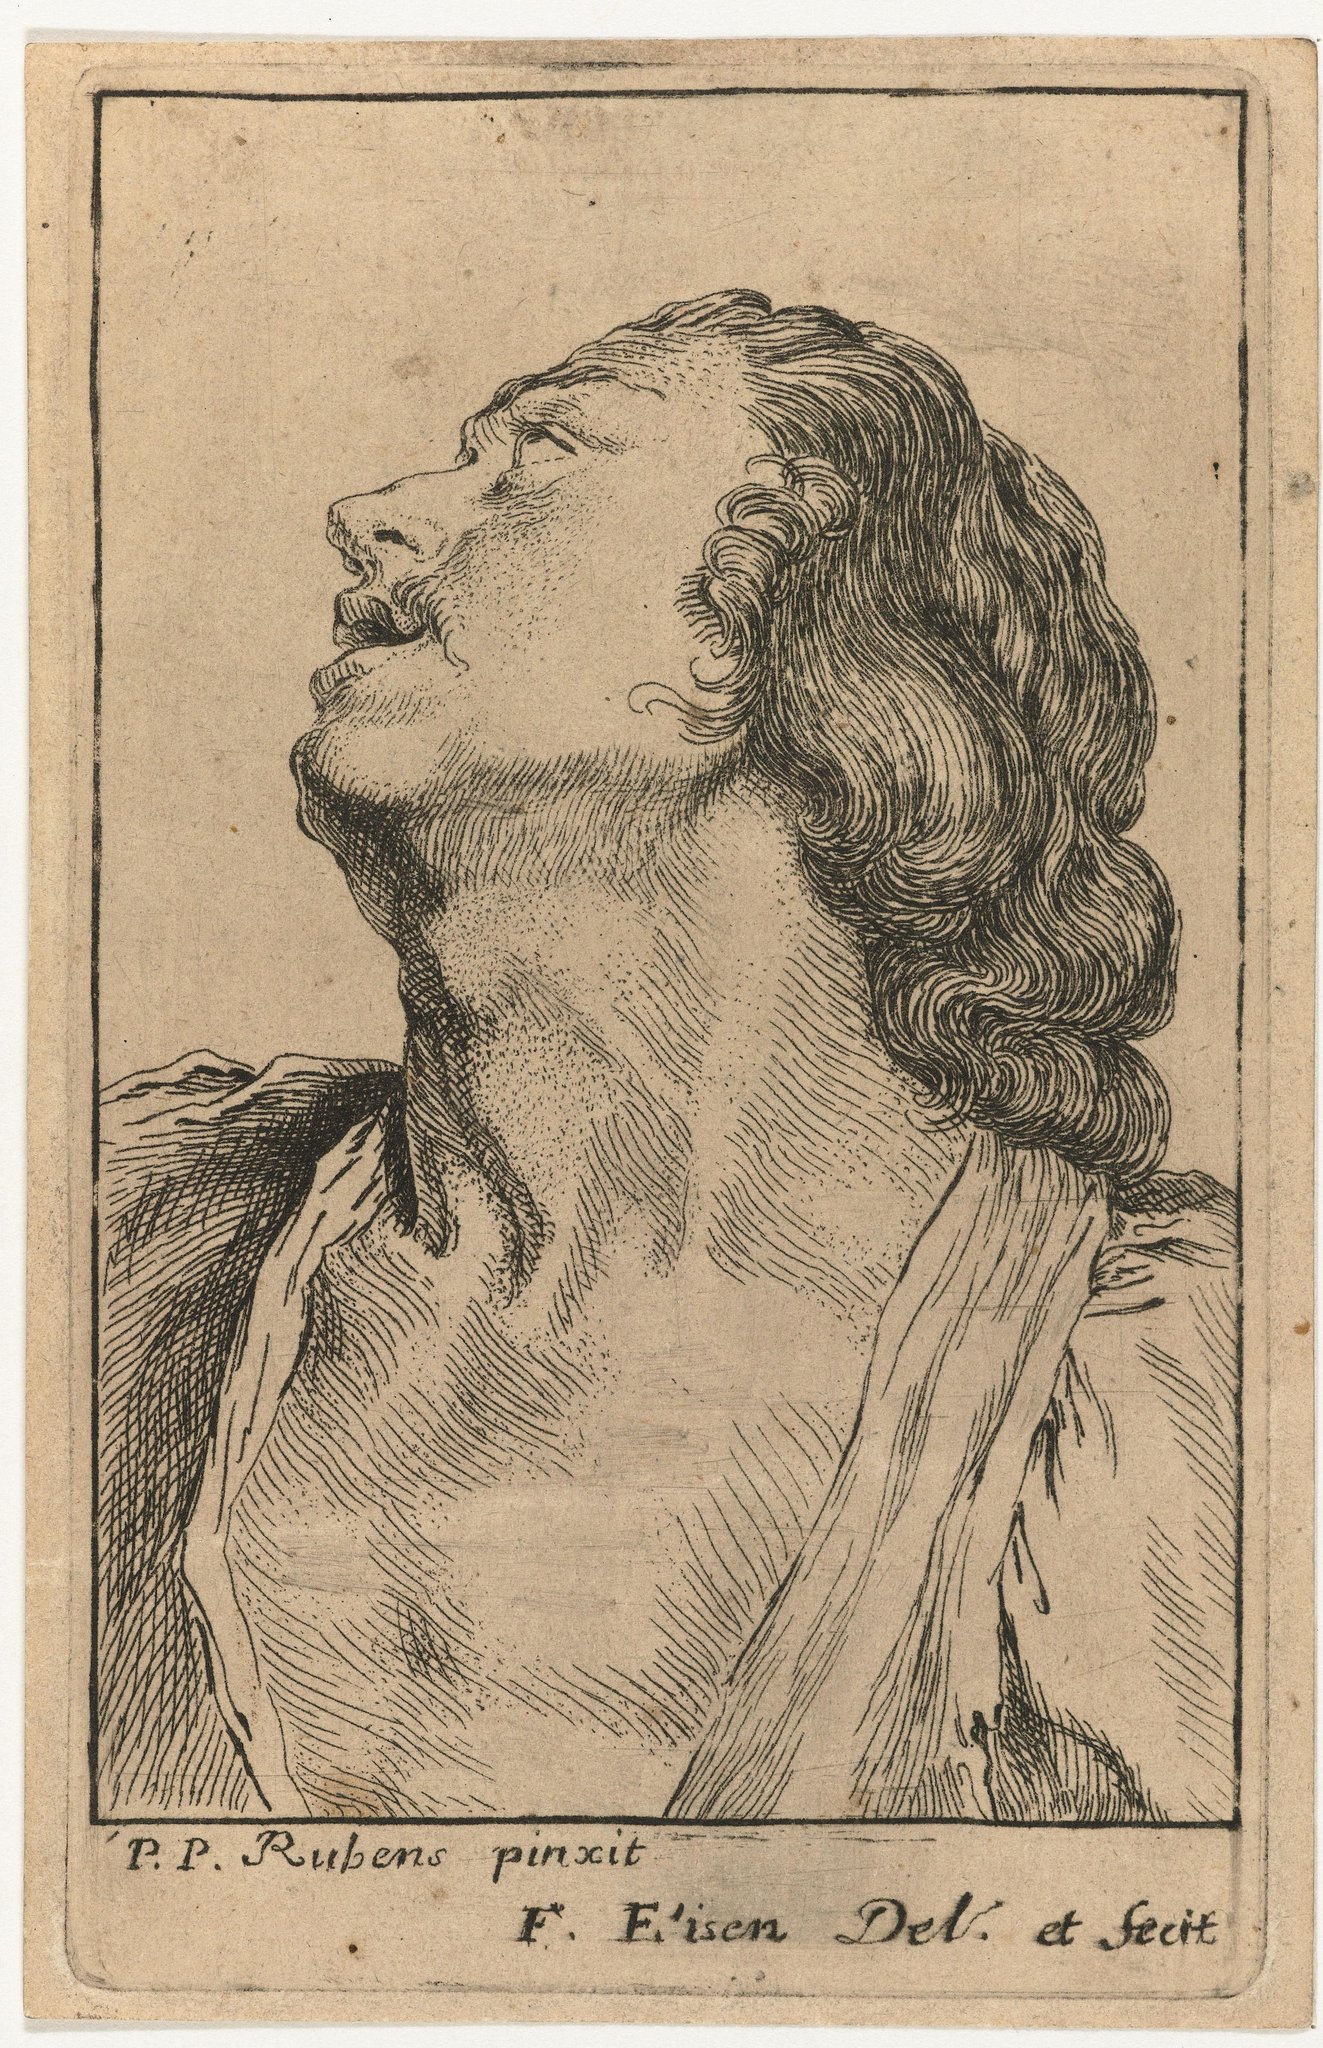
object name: print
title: Borstbeeld van een jongeman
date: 1705-1778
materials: paper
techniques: etching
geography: paris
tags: adult man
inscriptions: collector's mark: Lugt 2228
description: Studiebeeld. Borstbeeld van een jongeman met lang haar, hij buigt het hoofd dat in profiel links is gewend naar achteren, zijn borst is ontbloot.